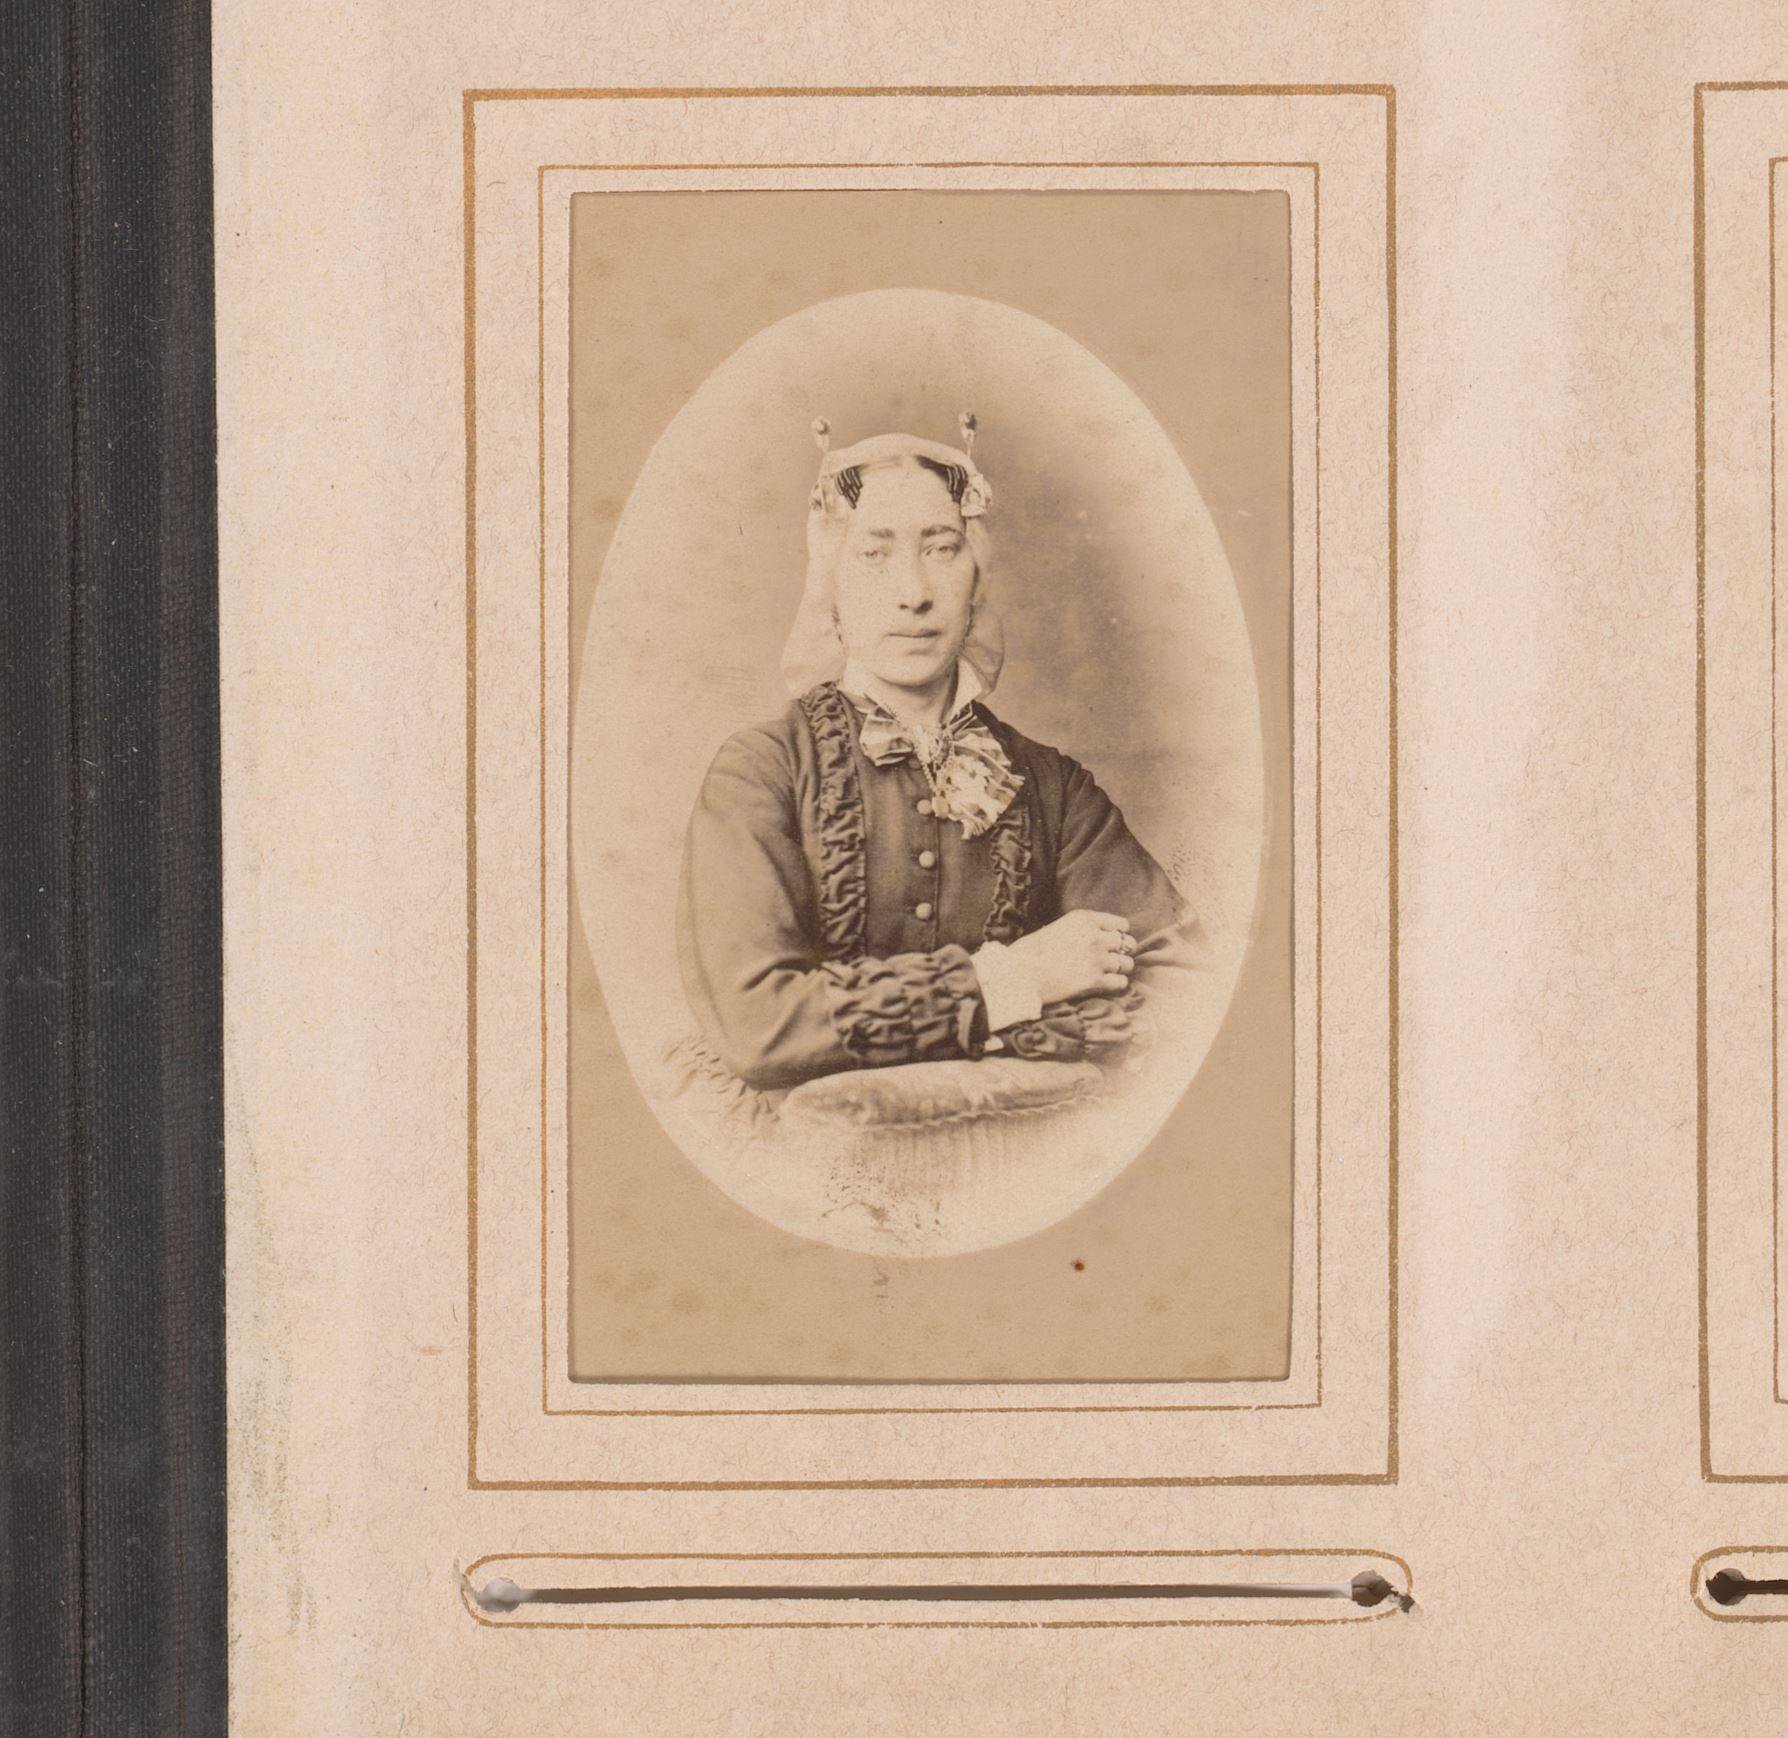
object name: photograph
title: Portret van een vrouw met muts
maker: anthony martinus hayo polman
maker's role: fotograaf, lithograaf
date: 1867-1878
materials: cardboard, photographic support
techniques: albumen print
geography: nieuwediep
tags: historical persons - bb - woman, head-gear: hat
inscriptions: inscription: ‘Polman/ Hoofdgracht/ K 44/ Nieuwe Diep’